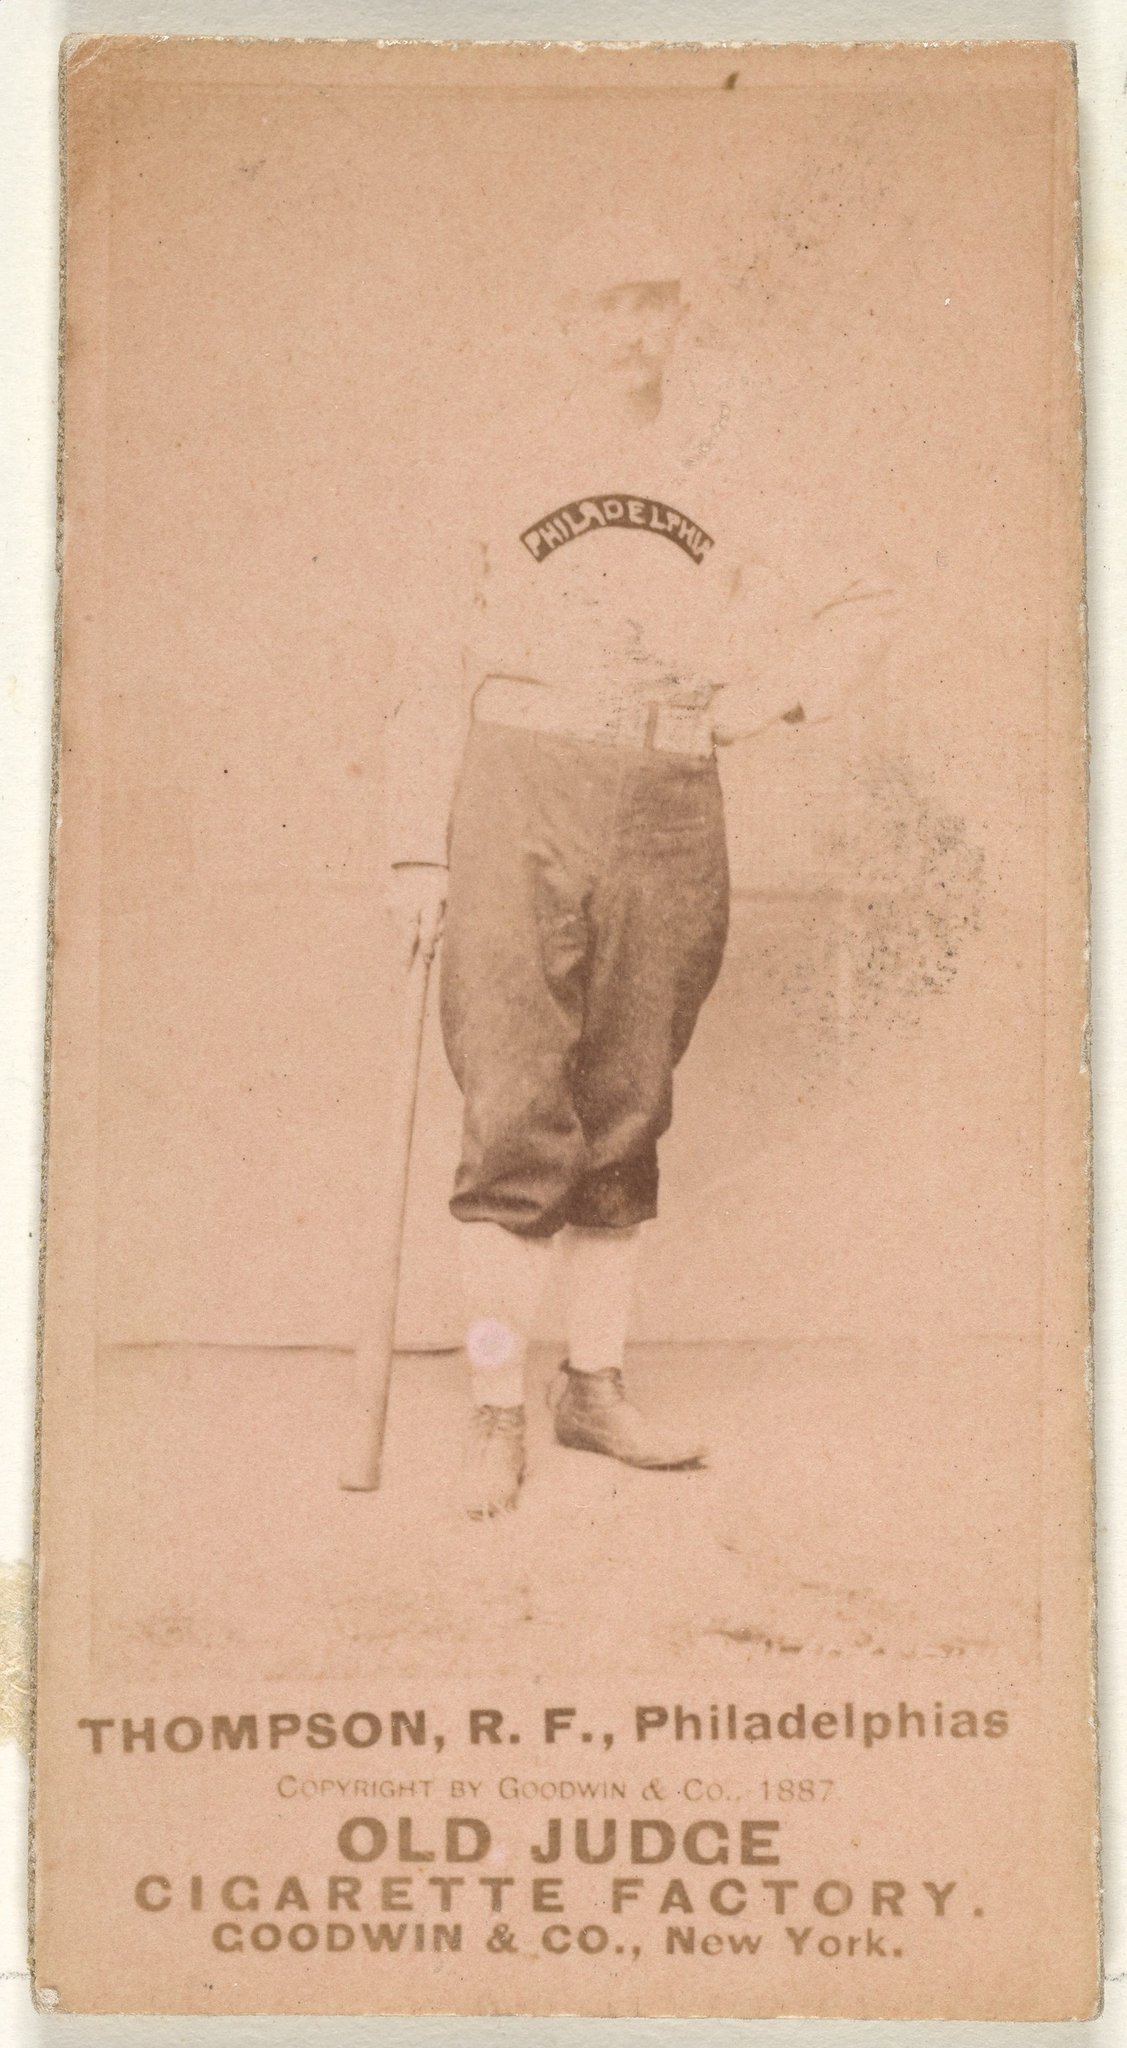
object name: baseball card, photograph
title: Thompson, Right Field, Philadelphia, from the Old Judge series (N172) for Old Judge Cigarettes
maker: goodwin & company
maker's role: publisher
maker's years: 1850-1950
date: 1887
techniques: albumen silver print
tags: men,portraits,baseball,athletes